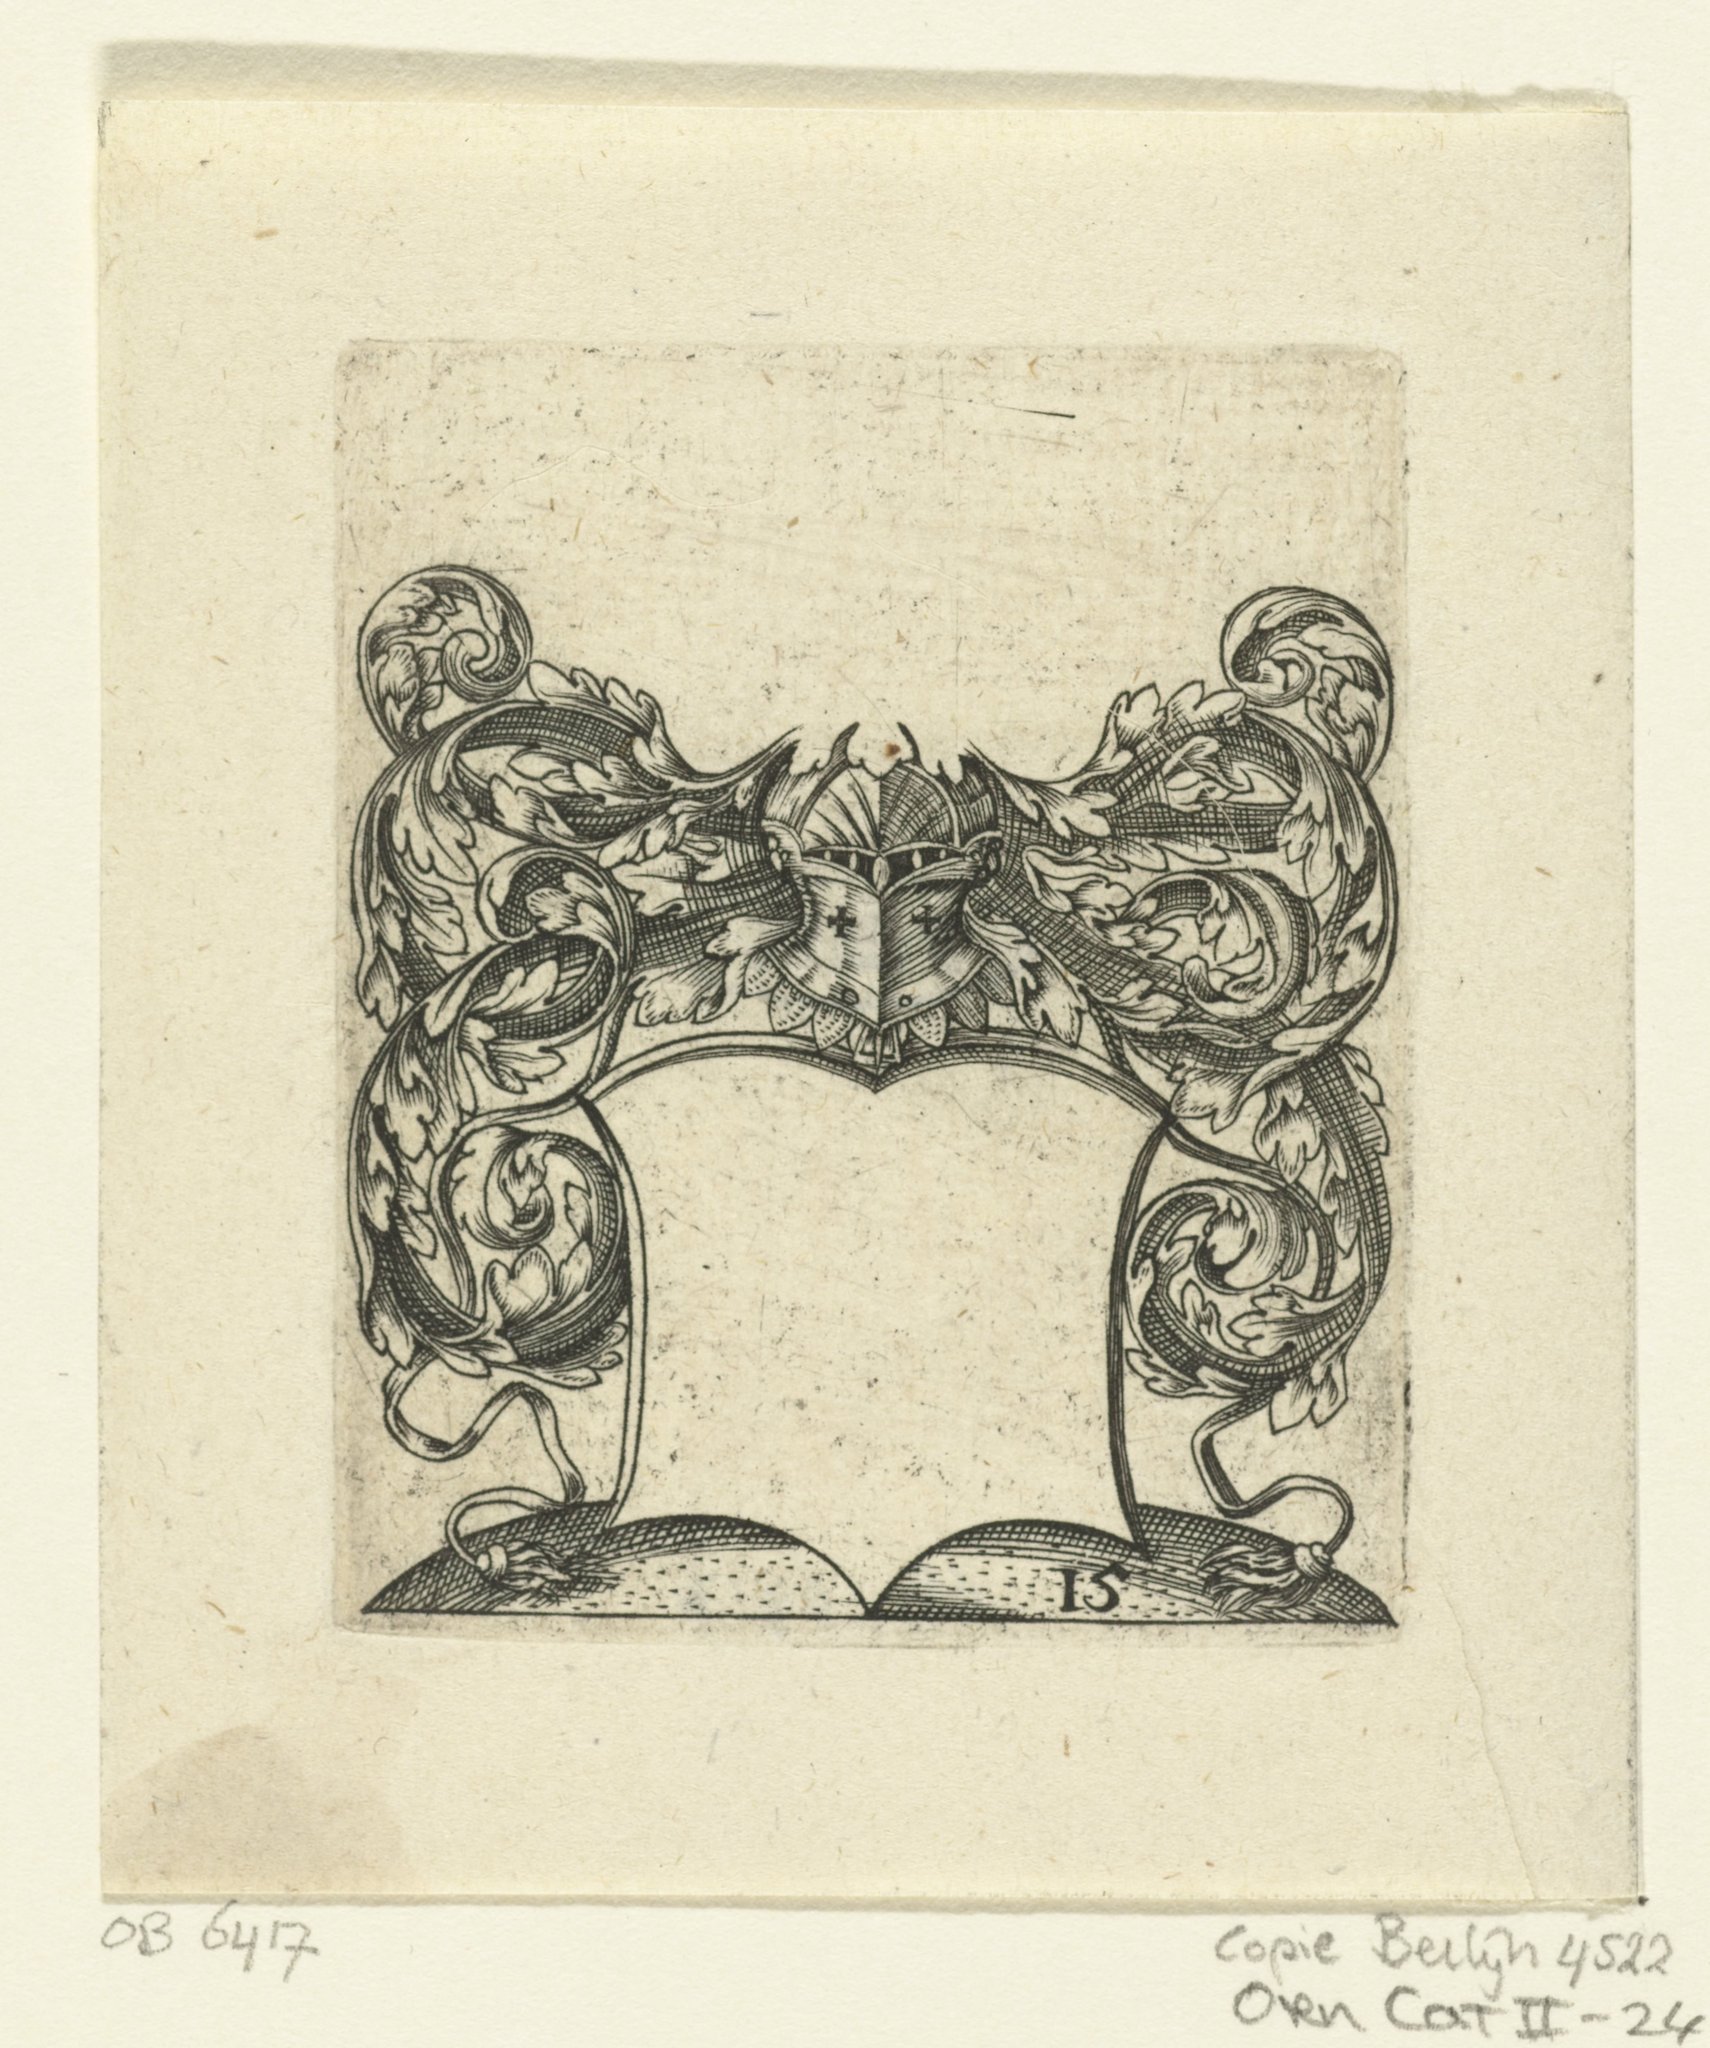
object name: ornament print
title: Verscheyden Wapenen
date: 1625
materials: paper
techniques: engraving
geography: amsterdam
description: Aan beide kanten zijn drie bladranken te zien. Tegenzijdige kopie naar wapenschild van Theodor de Bry in het boek Emblemata Nobilitati.... Blad uit serie wapenschilden met lege compartimenten.